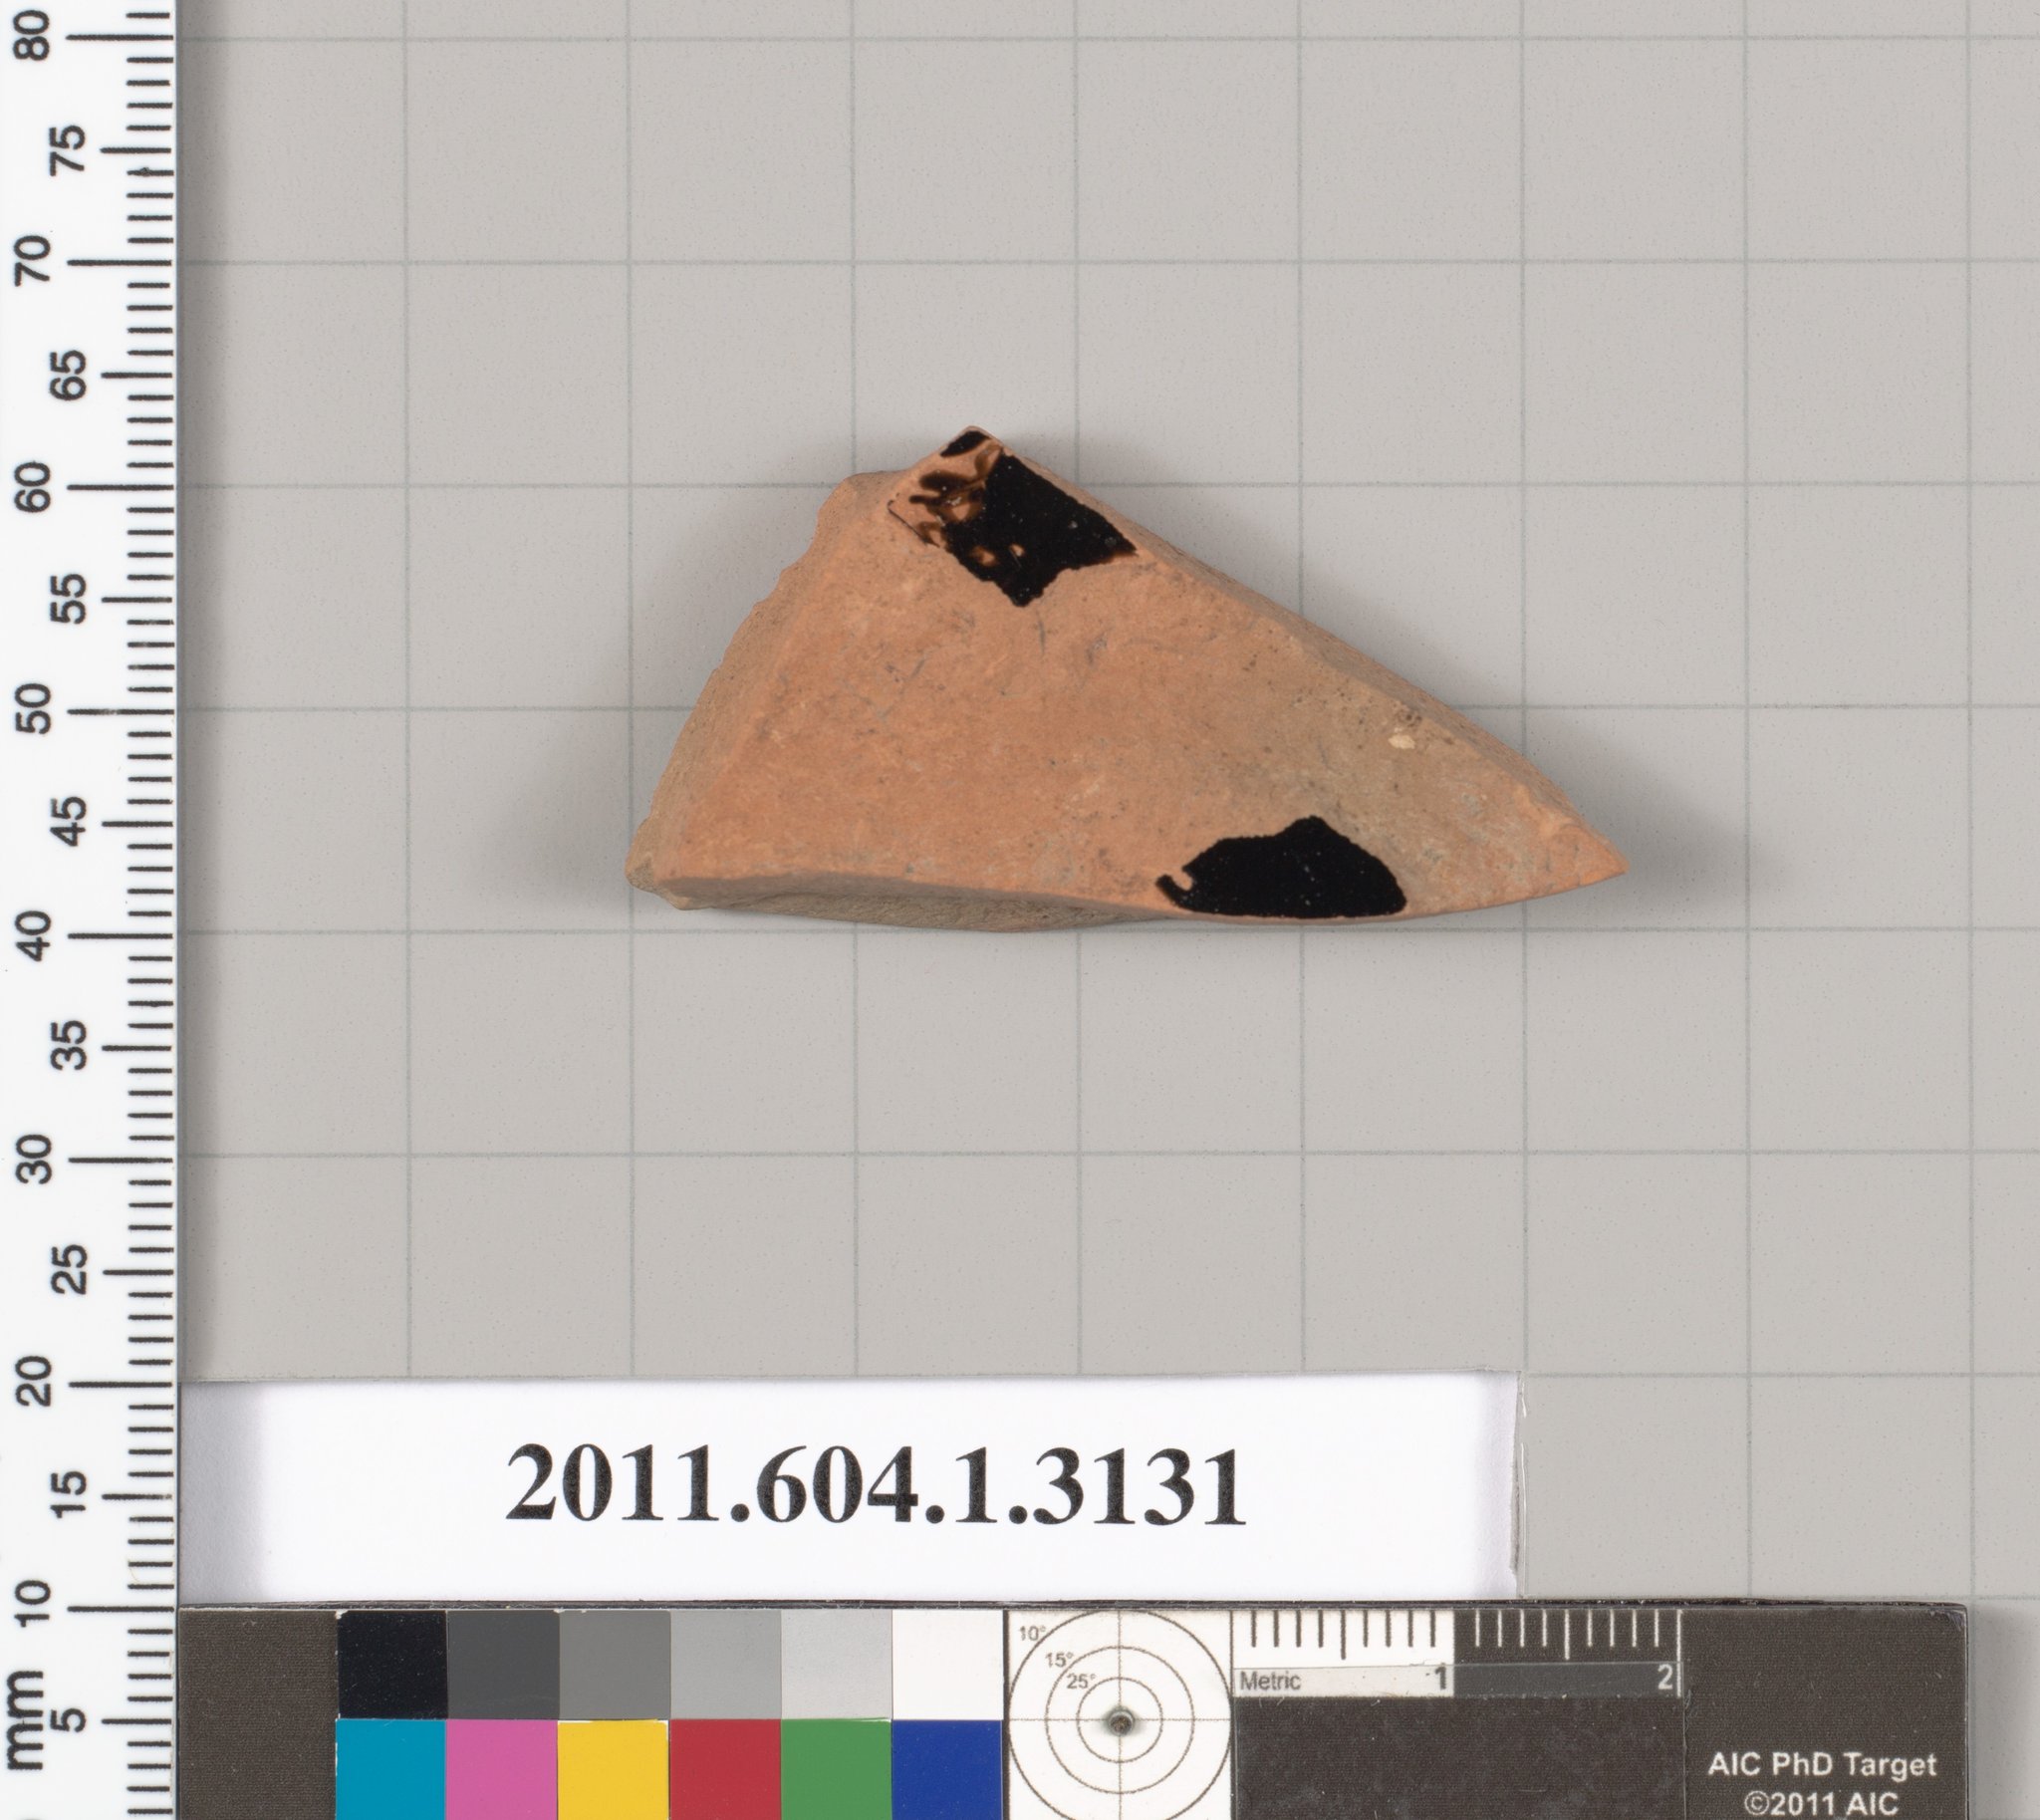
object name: kylix fragment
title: Terracotta fragment of a kylix (drinking cup)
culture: greek, attic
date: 500-451 BCE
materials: terracotta